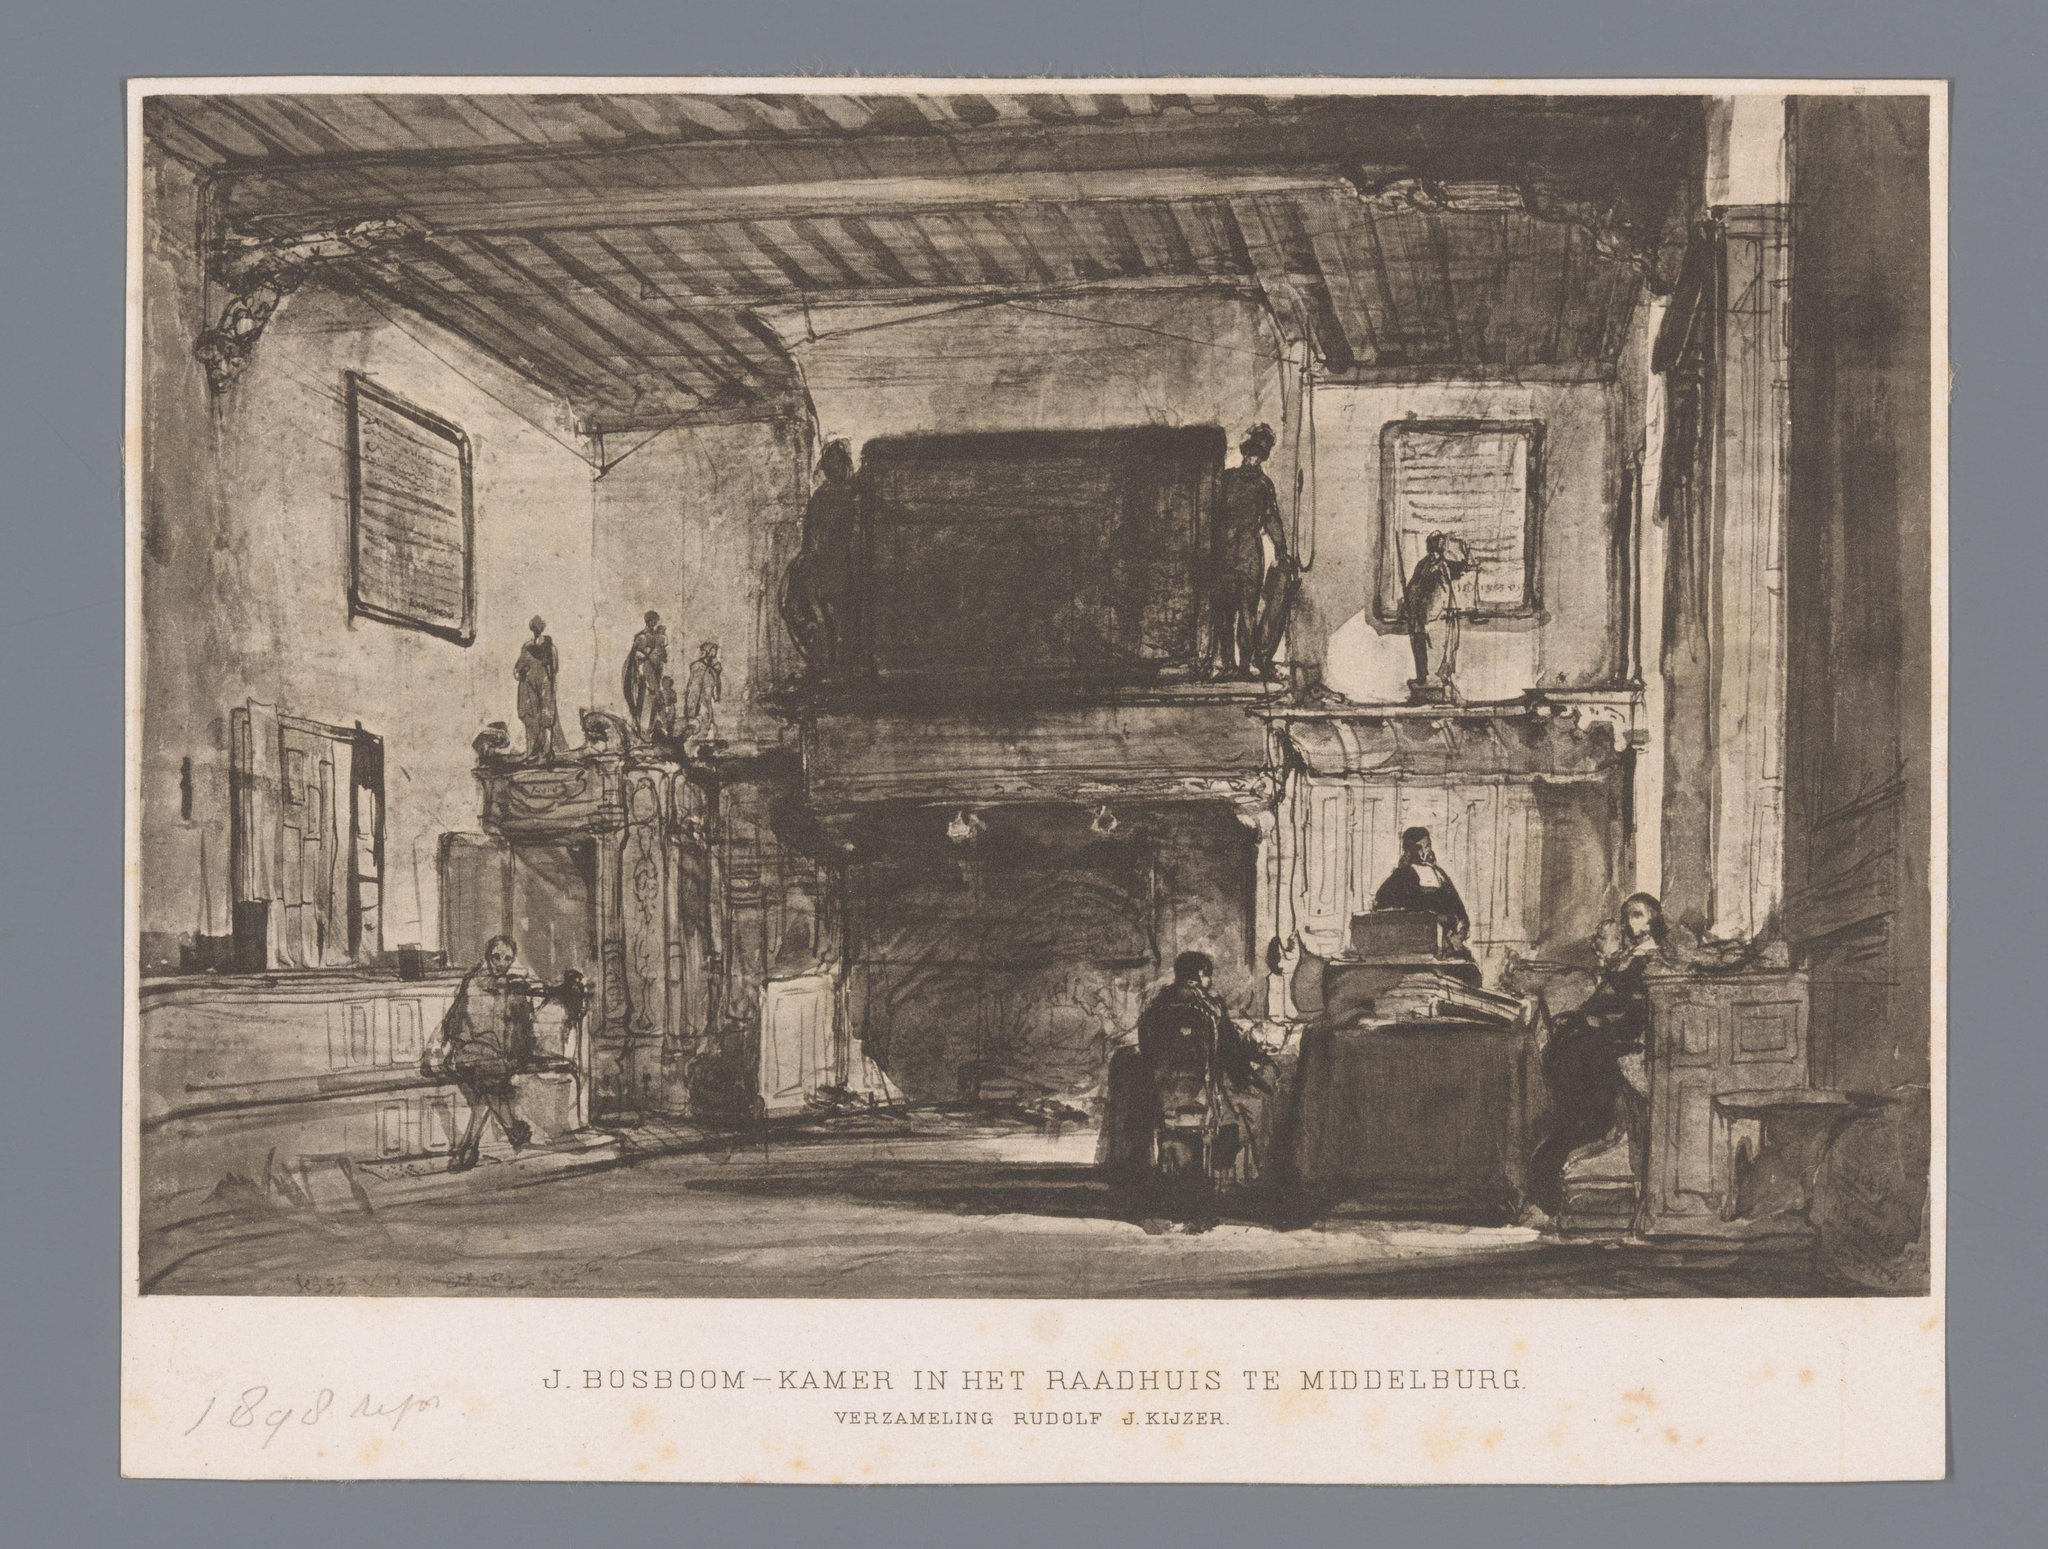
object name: photomechanical print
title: J. Bosboom - Kamer in het Raadhuis te Middelburg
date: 1898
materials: paper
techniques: photograph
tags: townhall, court-room